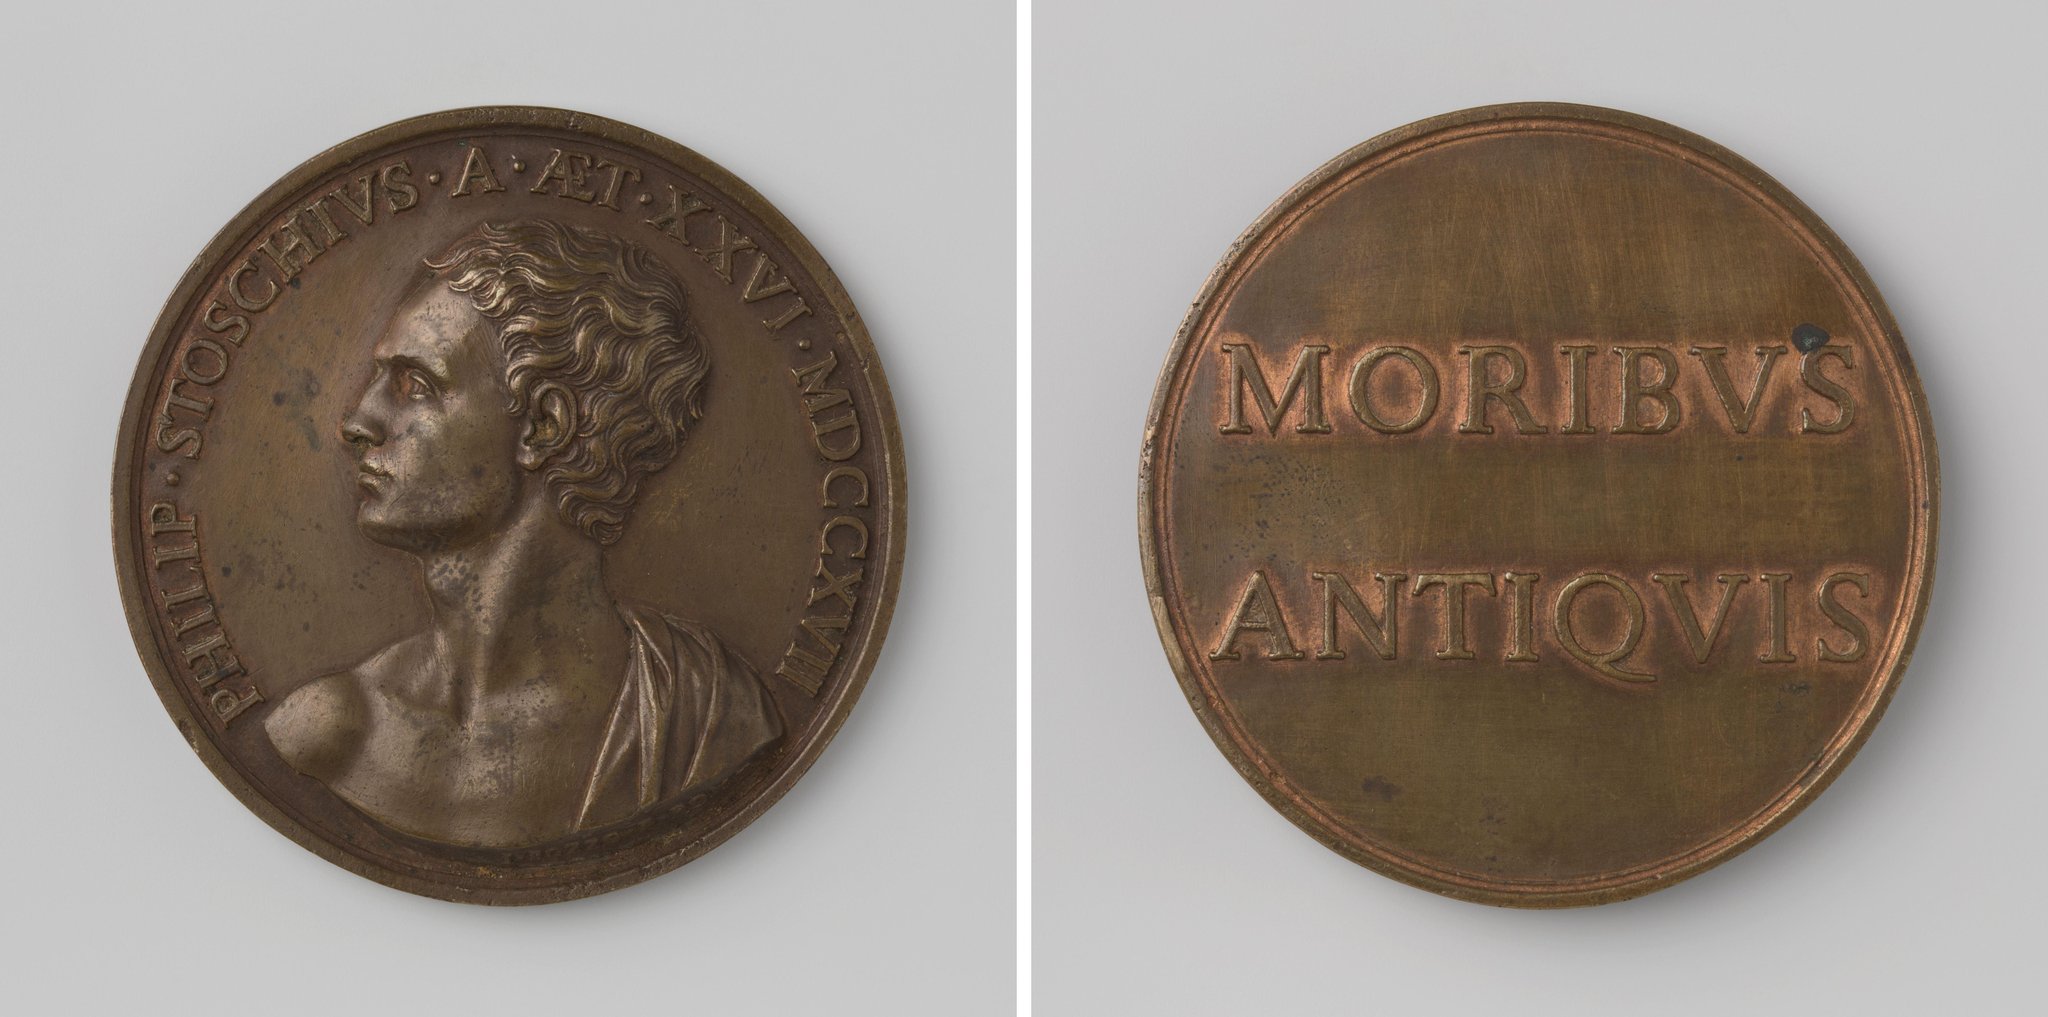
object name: honorary medal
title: Philip, baron von Stosch, antiquair, archeoloog en verzamelaar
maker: giovanni battista pozzi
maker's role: medailleur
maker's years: 1670-1752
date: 1717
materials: bronze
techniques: casting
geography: rome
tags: kostrzyn nad odrą, verzamelaar, archeoloog, philipp stosch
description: Bronzen penning. Voorzijde: borststuk man binnen omschrift. Keerzijde: opschrift